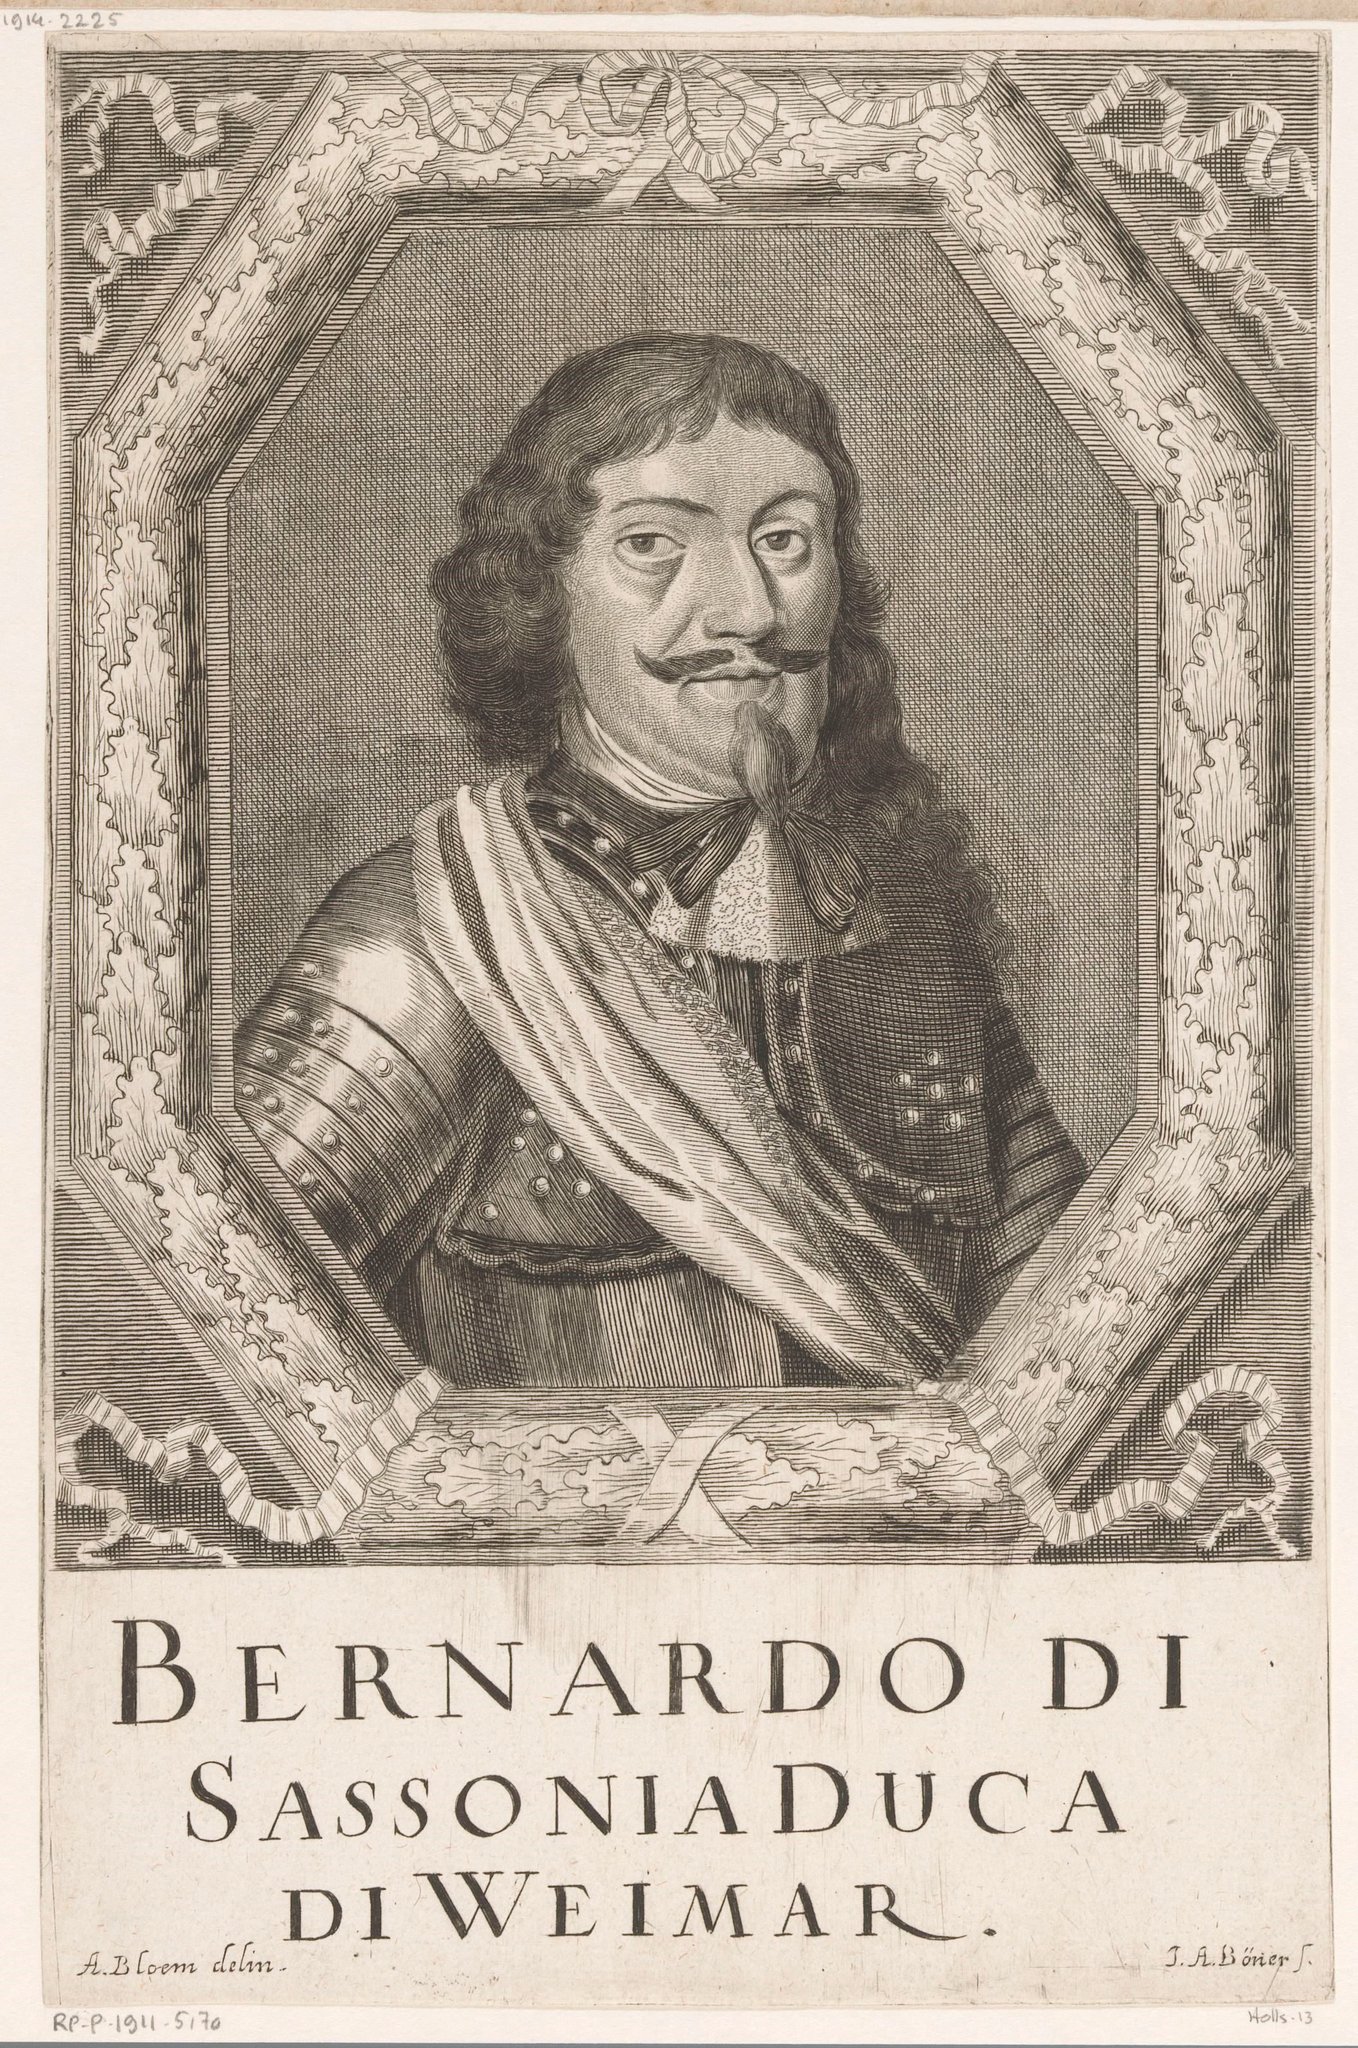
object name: print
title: Portret van Bernhard, hertog van Saksen-Weimar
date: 1657-1720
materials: paper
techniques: engraving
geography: nuremberg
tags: historical persons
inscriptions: collector's mark: Lugt 2228